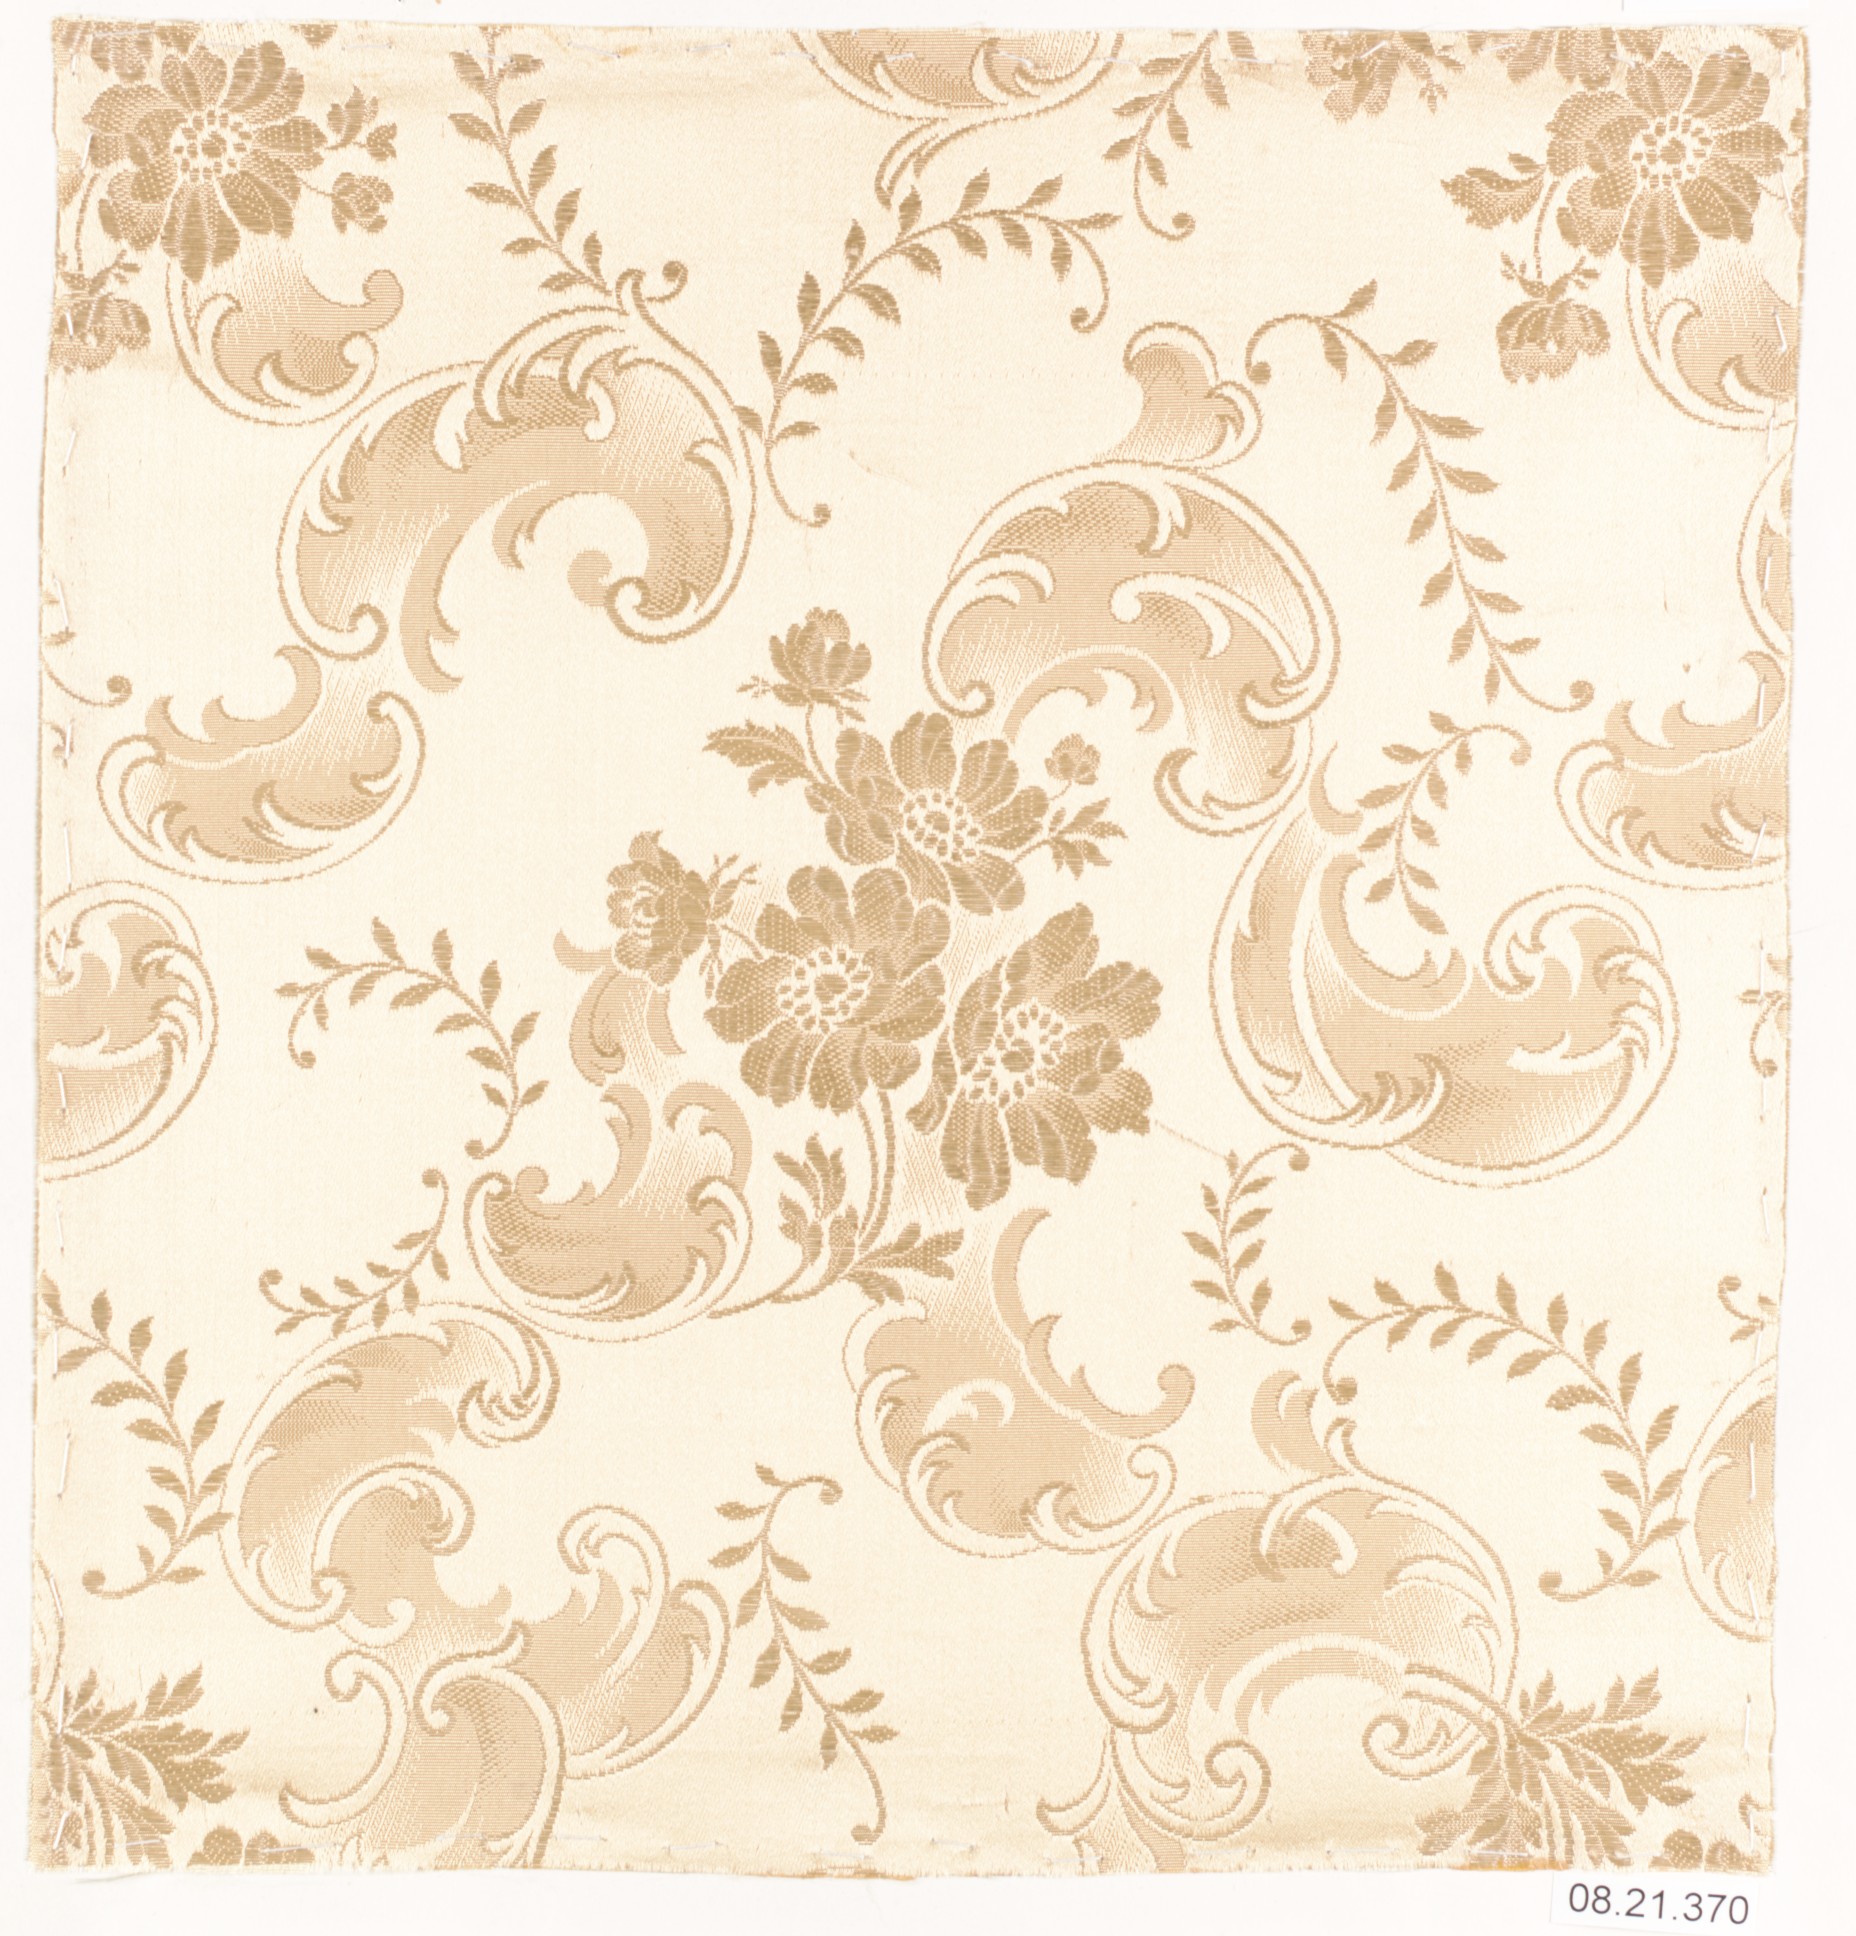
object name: textile sample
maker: Anonymous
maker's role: designer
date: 1900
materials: silk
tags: flowers